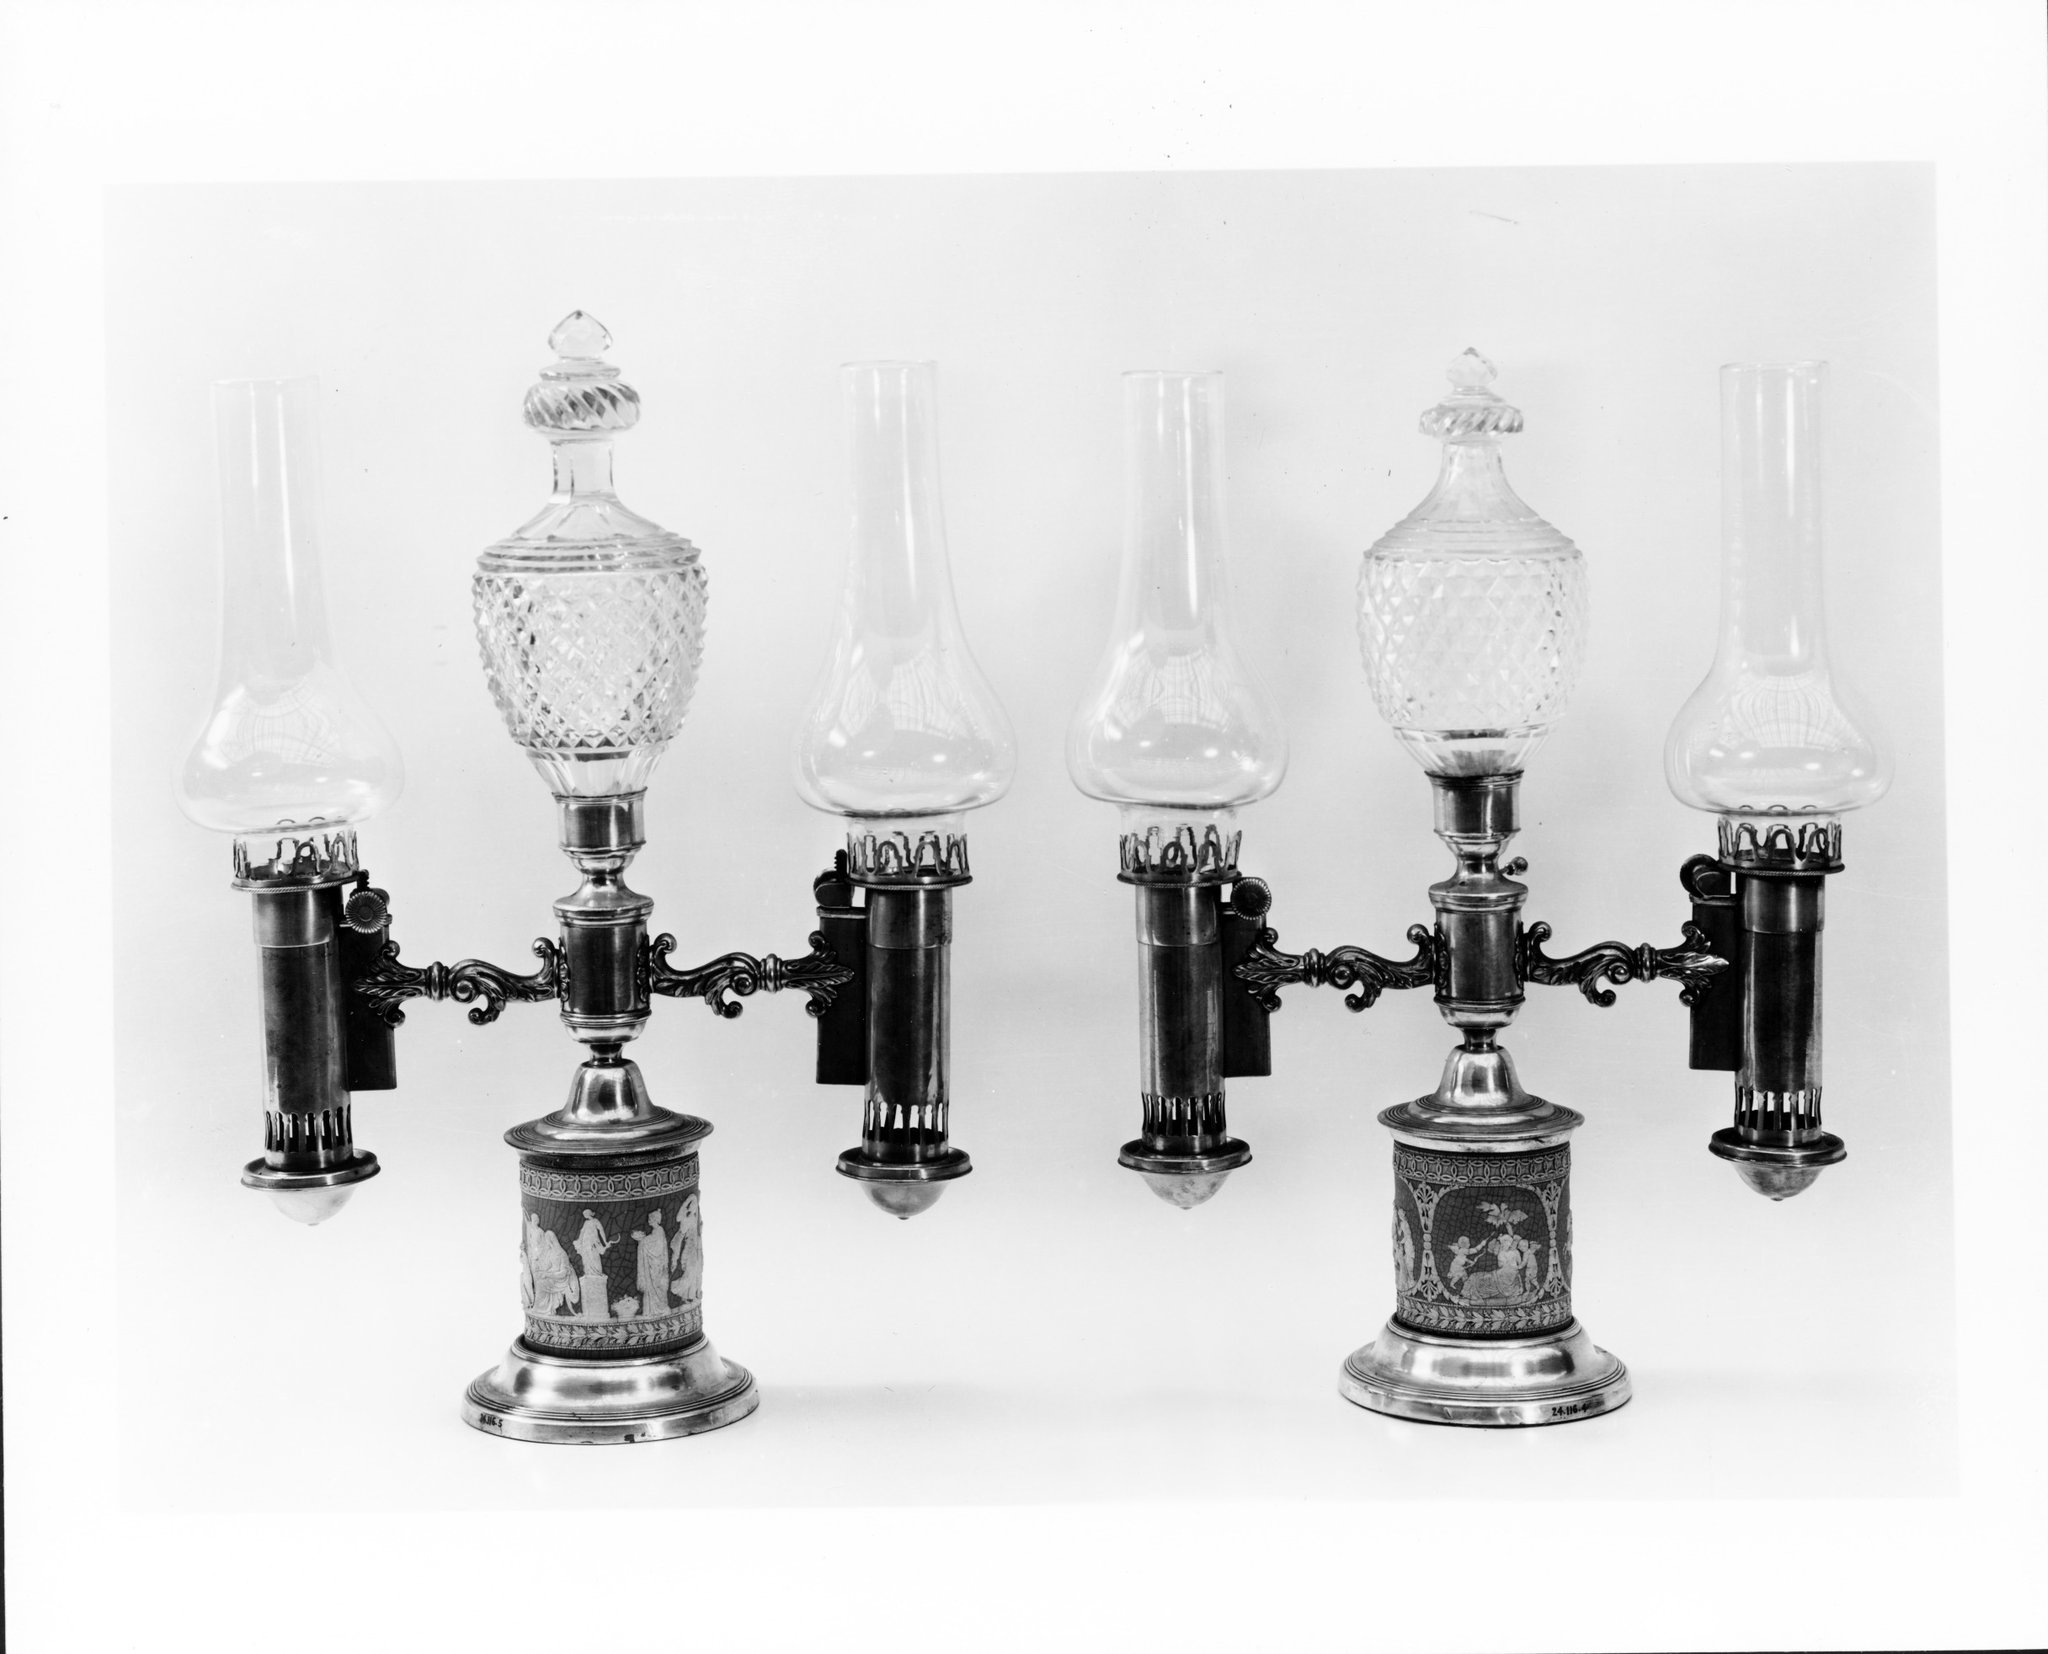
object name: argand lamp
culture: british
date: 1800-1815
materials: earthenware, glass, metal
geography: england